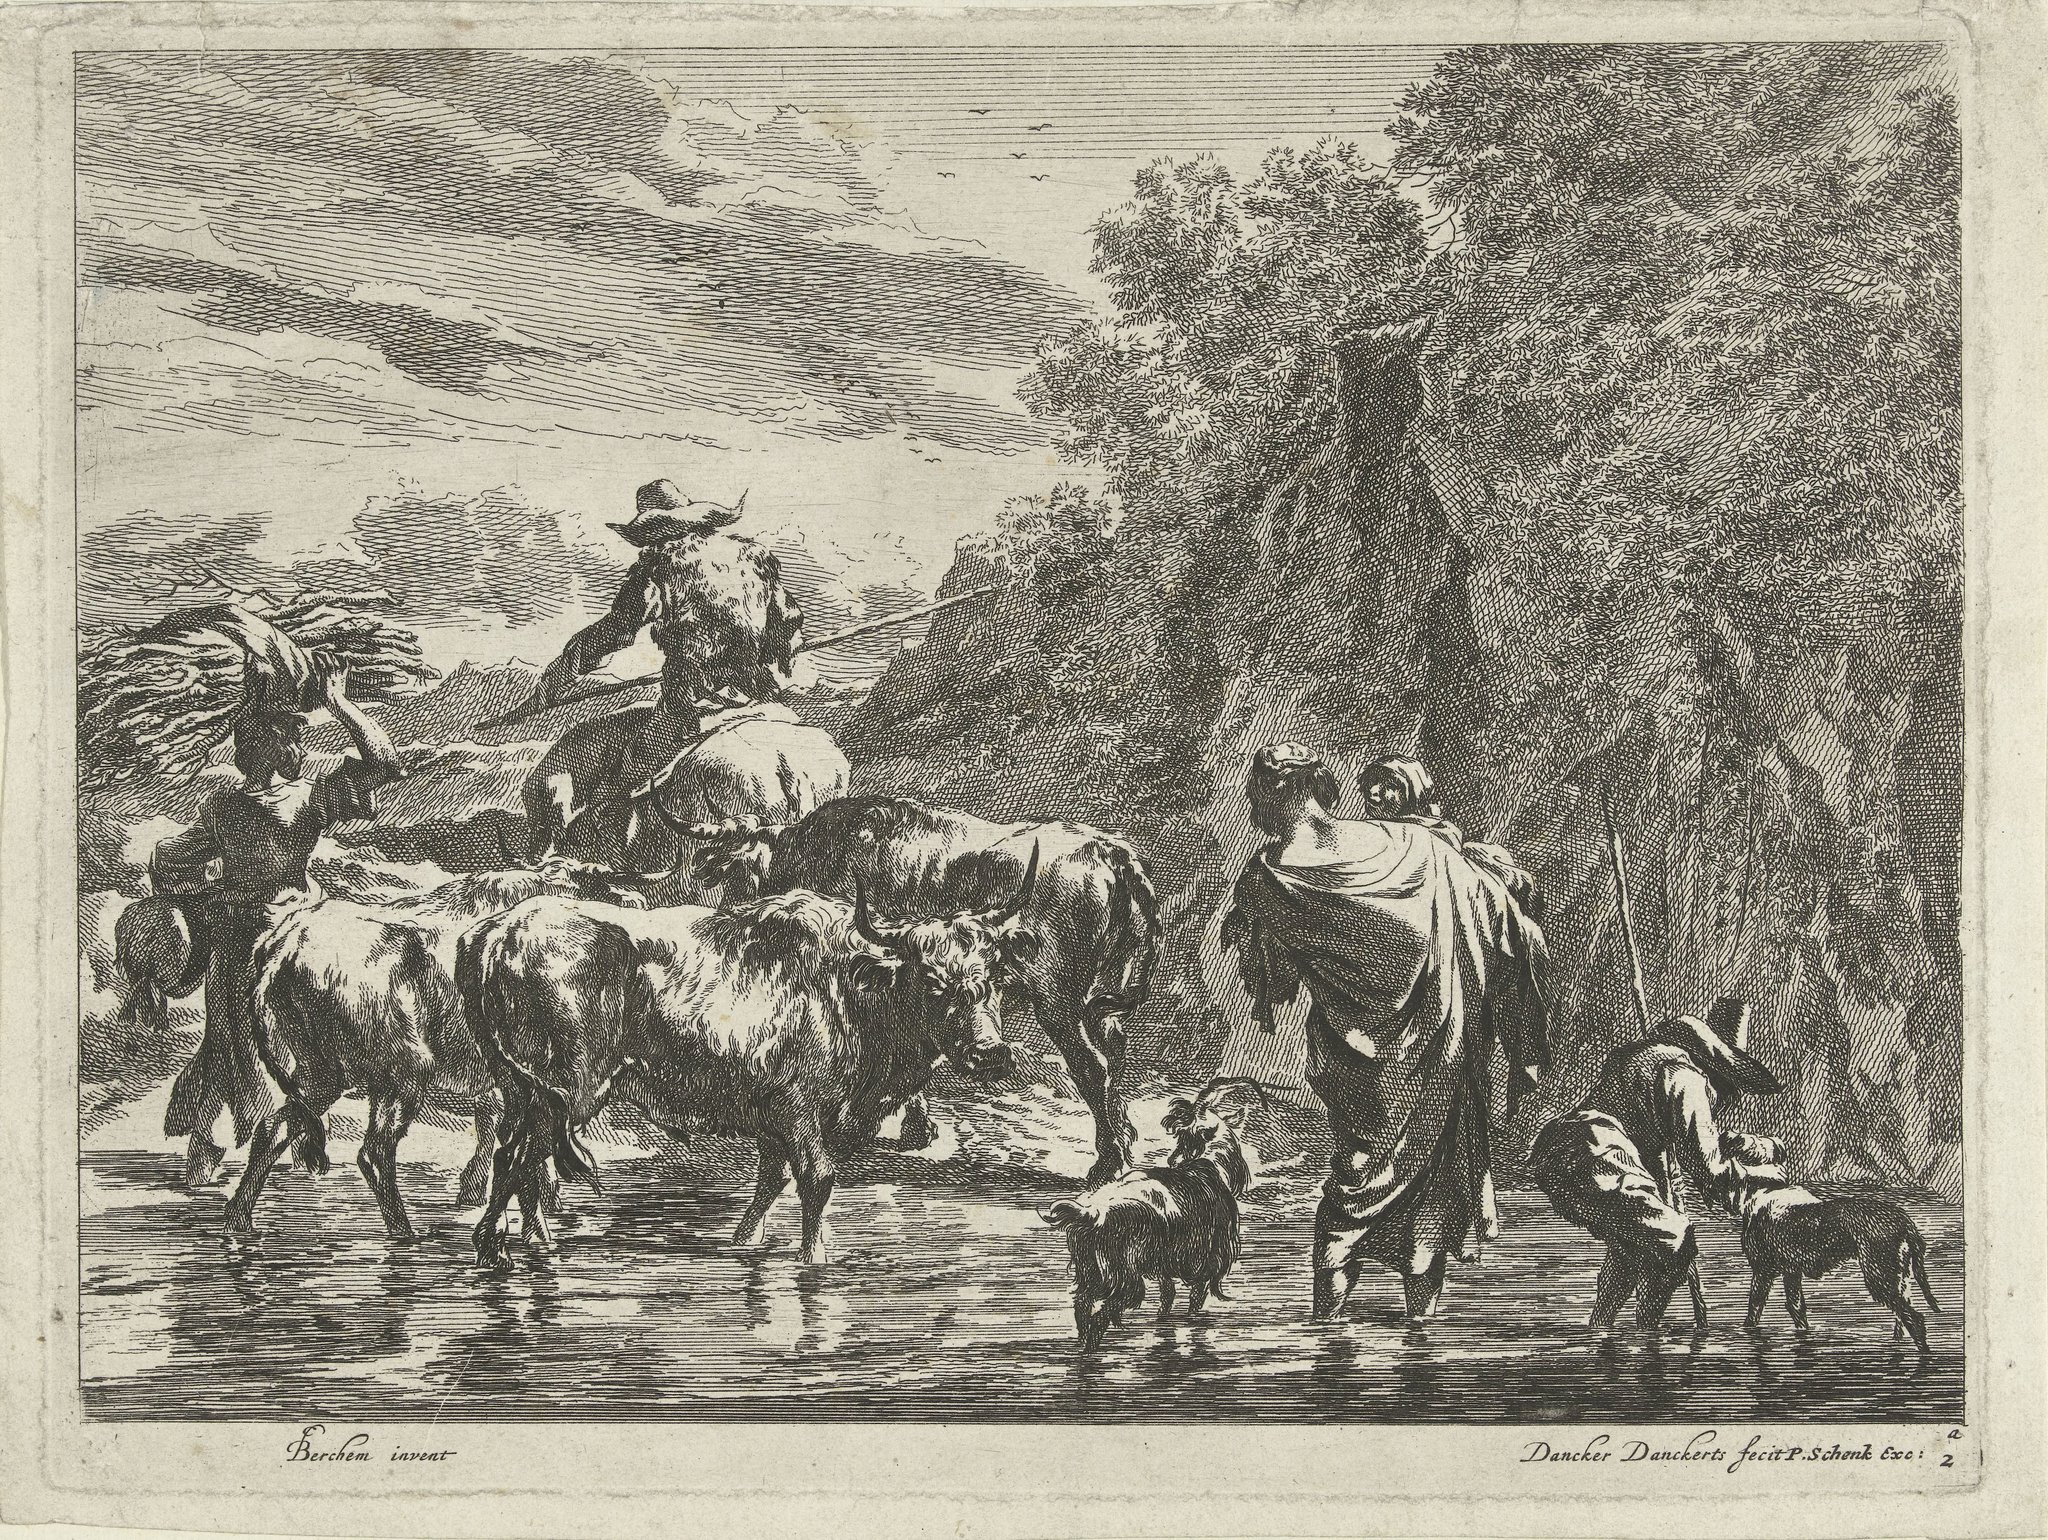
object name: print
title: Zuidelijke landschappen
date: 1643-1666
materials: paper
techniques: etching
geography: amsterdam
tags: crossing a river, herding, herdsman, herdswoman, shepherd, shepherdess, cowherd, etc., rocks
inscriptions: collector's mark: Lugt 2228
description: Prent uit serie van zes landschappen naar ontwerp van Nicolaes Pietersz. Berchem. De nummering van de serie in de derde staat wijkt mogelijk af van de samenstelling in voorgaande staten. Het is onduidelijk waar de letter a voor staat, deze komt terug op enkele prenten in de uitgave van Petrus Schenk of Frederik de Wit.